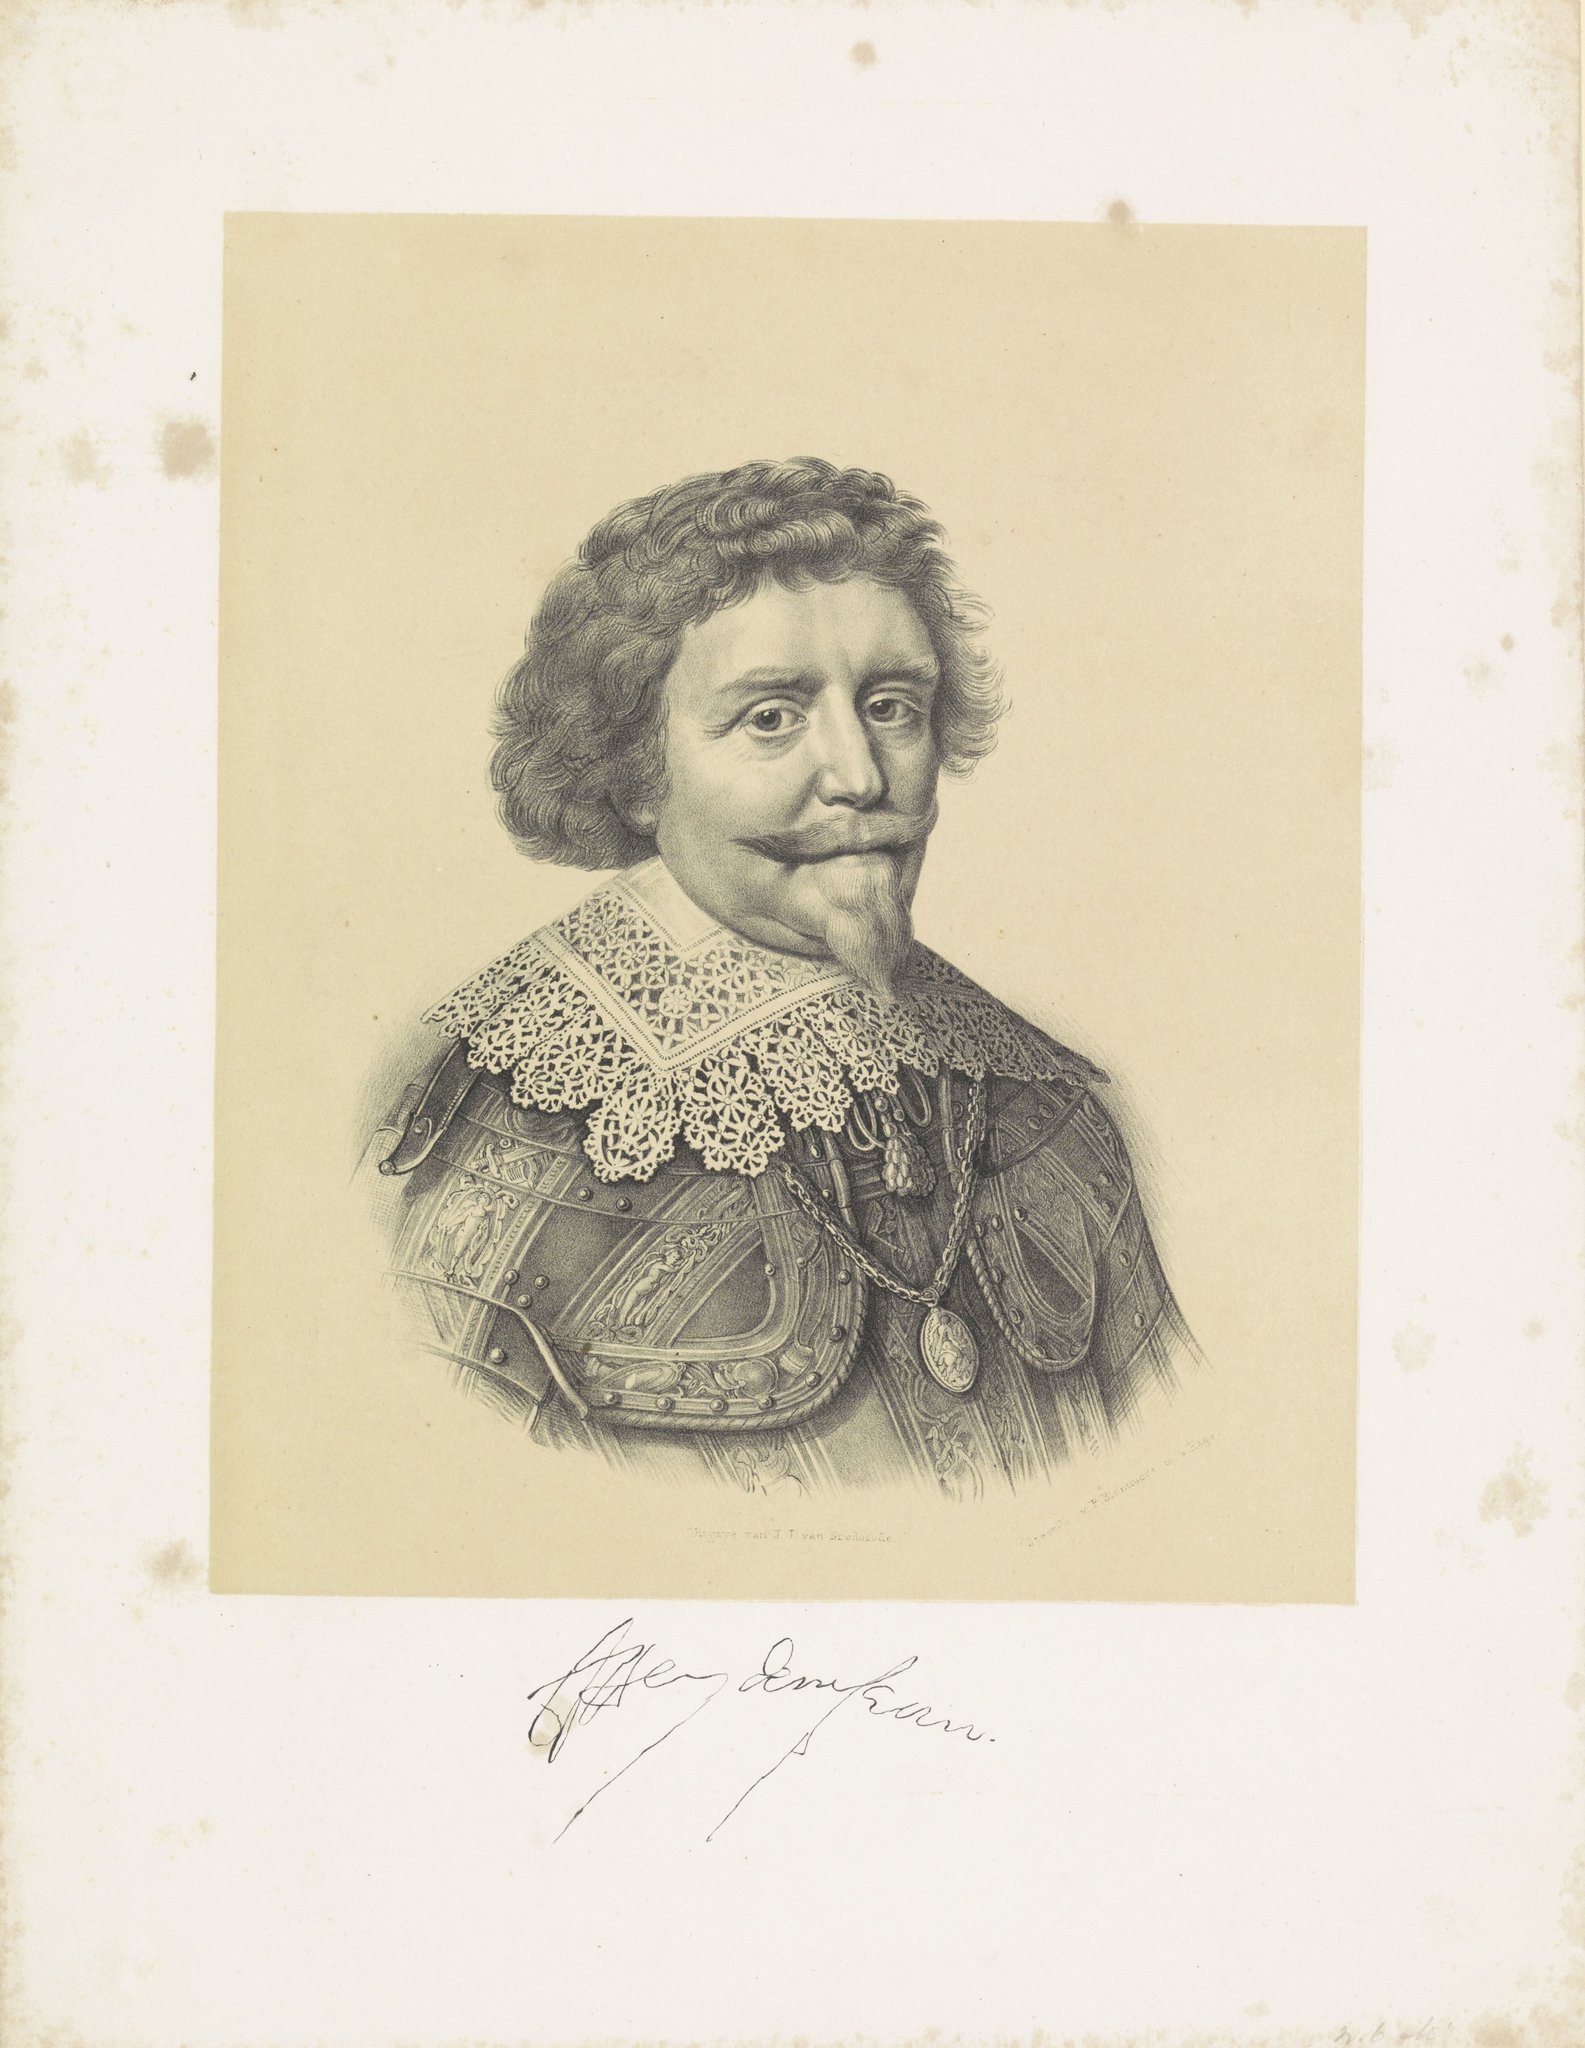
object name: print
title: Portret van Frederik Hendrik, prins van Oranje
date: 1847-1883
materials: paper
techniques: tone lithography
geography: netherlands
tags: delft, the hague, frederick henry (prince of orange), knighthood order (garter) - insignia of a knighthood order, e.g.: badge, chain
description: De hier vermelde titel verwijst naar de hoogst verkregen titel van de geportretteerde, niet per se naar de titel die de geportretteerde op deze voorstelling draagt.